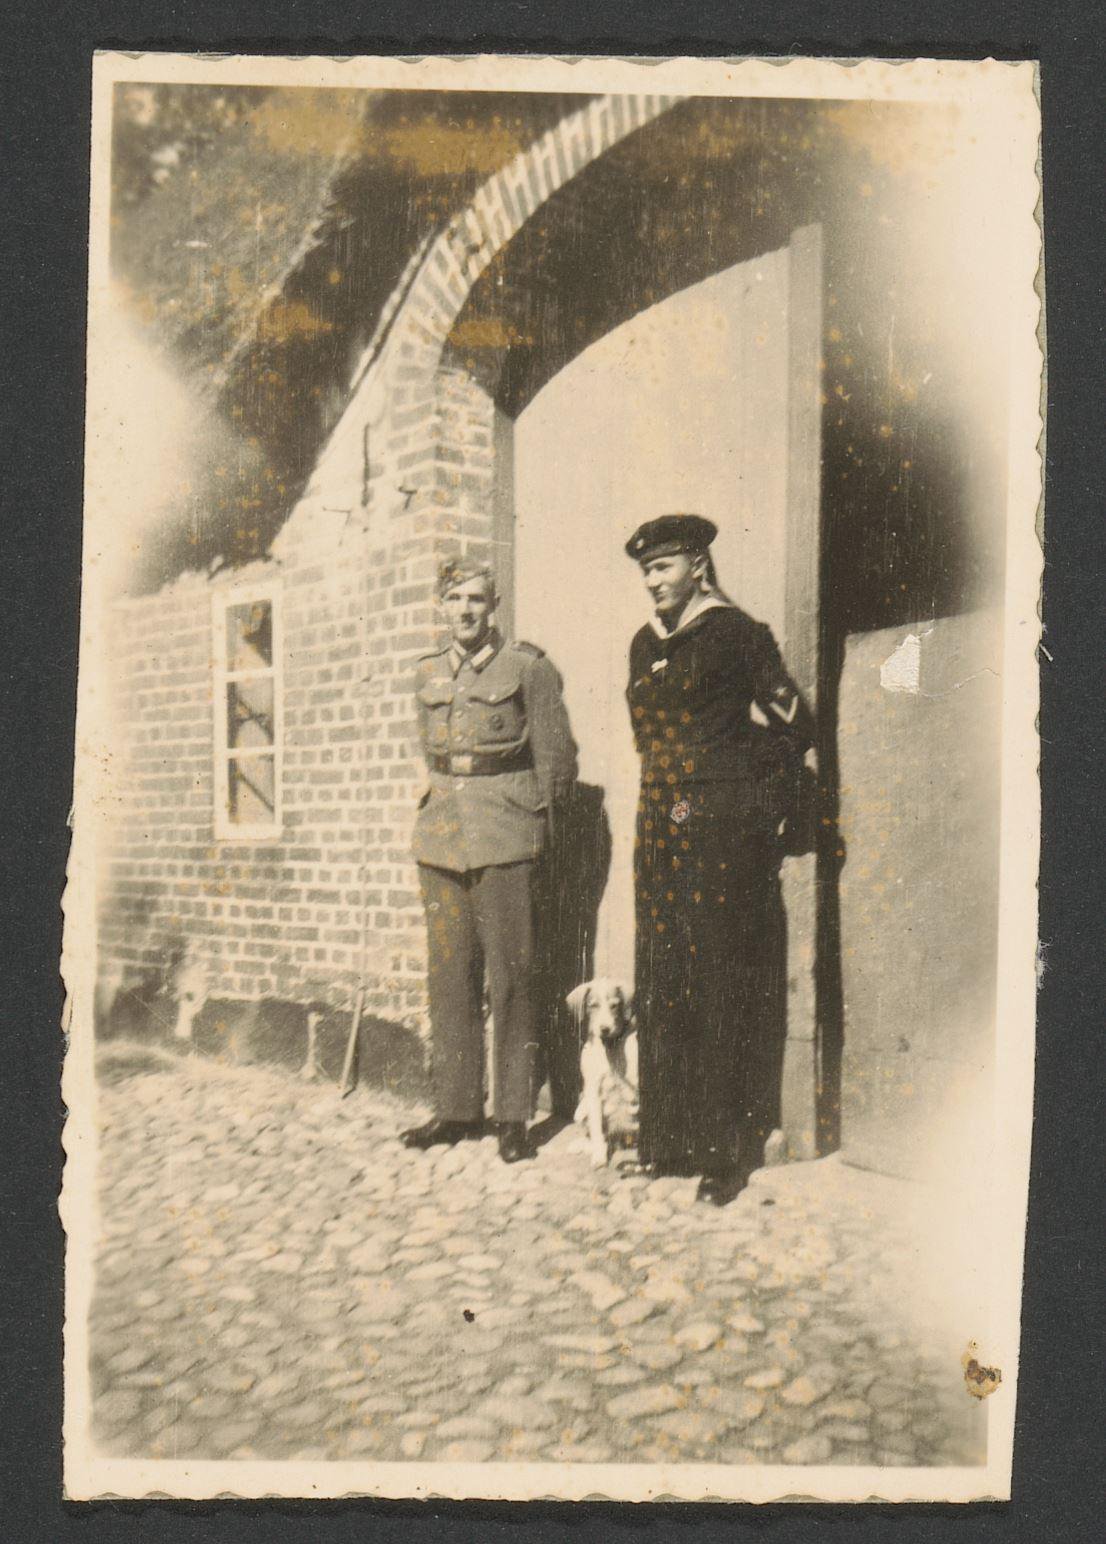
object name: album leaf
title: Twee militairen in uniform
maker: Anonymous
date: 1930-1945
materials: paper, photographic support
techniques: gelatin silver print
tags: adult man, the soldier; the soldier's life, (military) uniforms